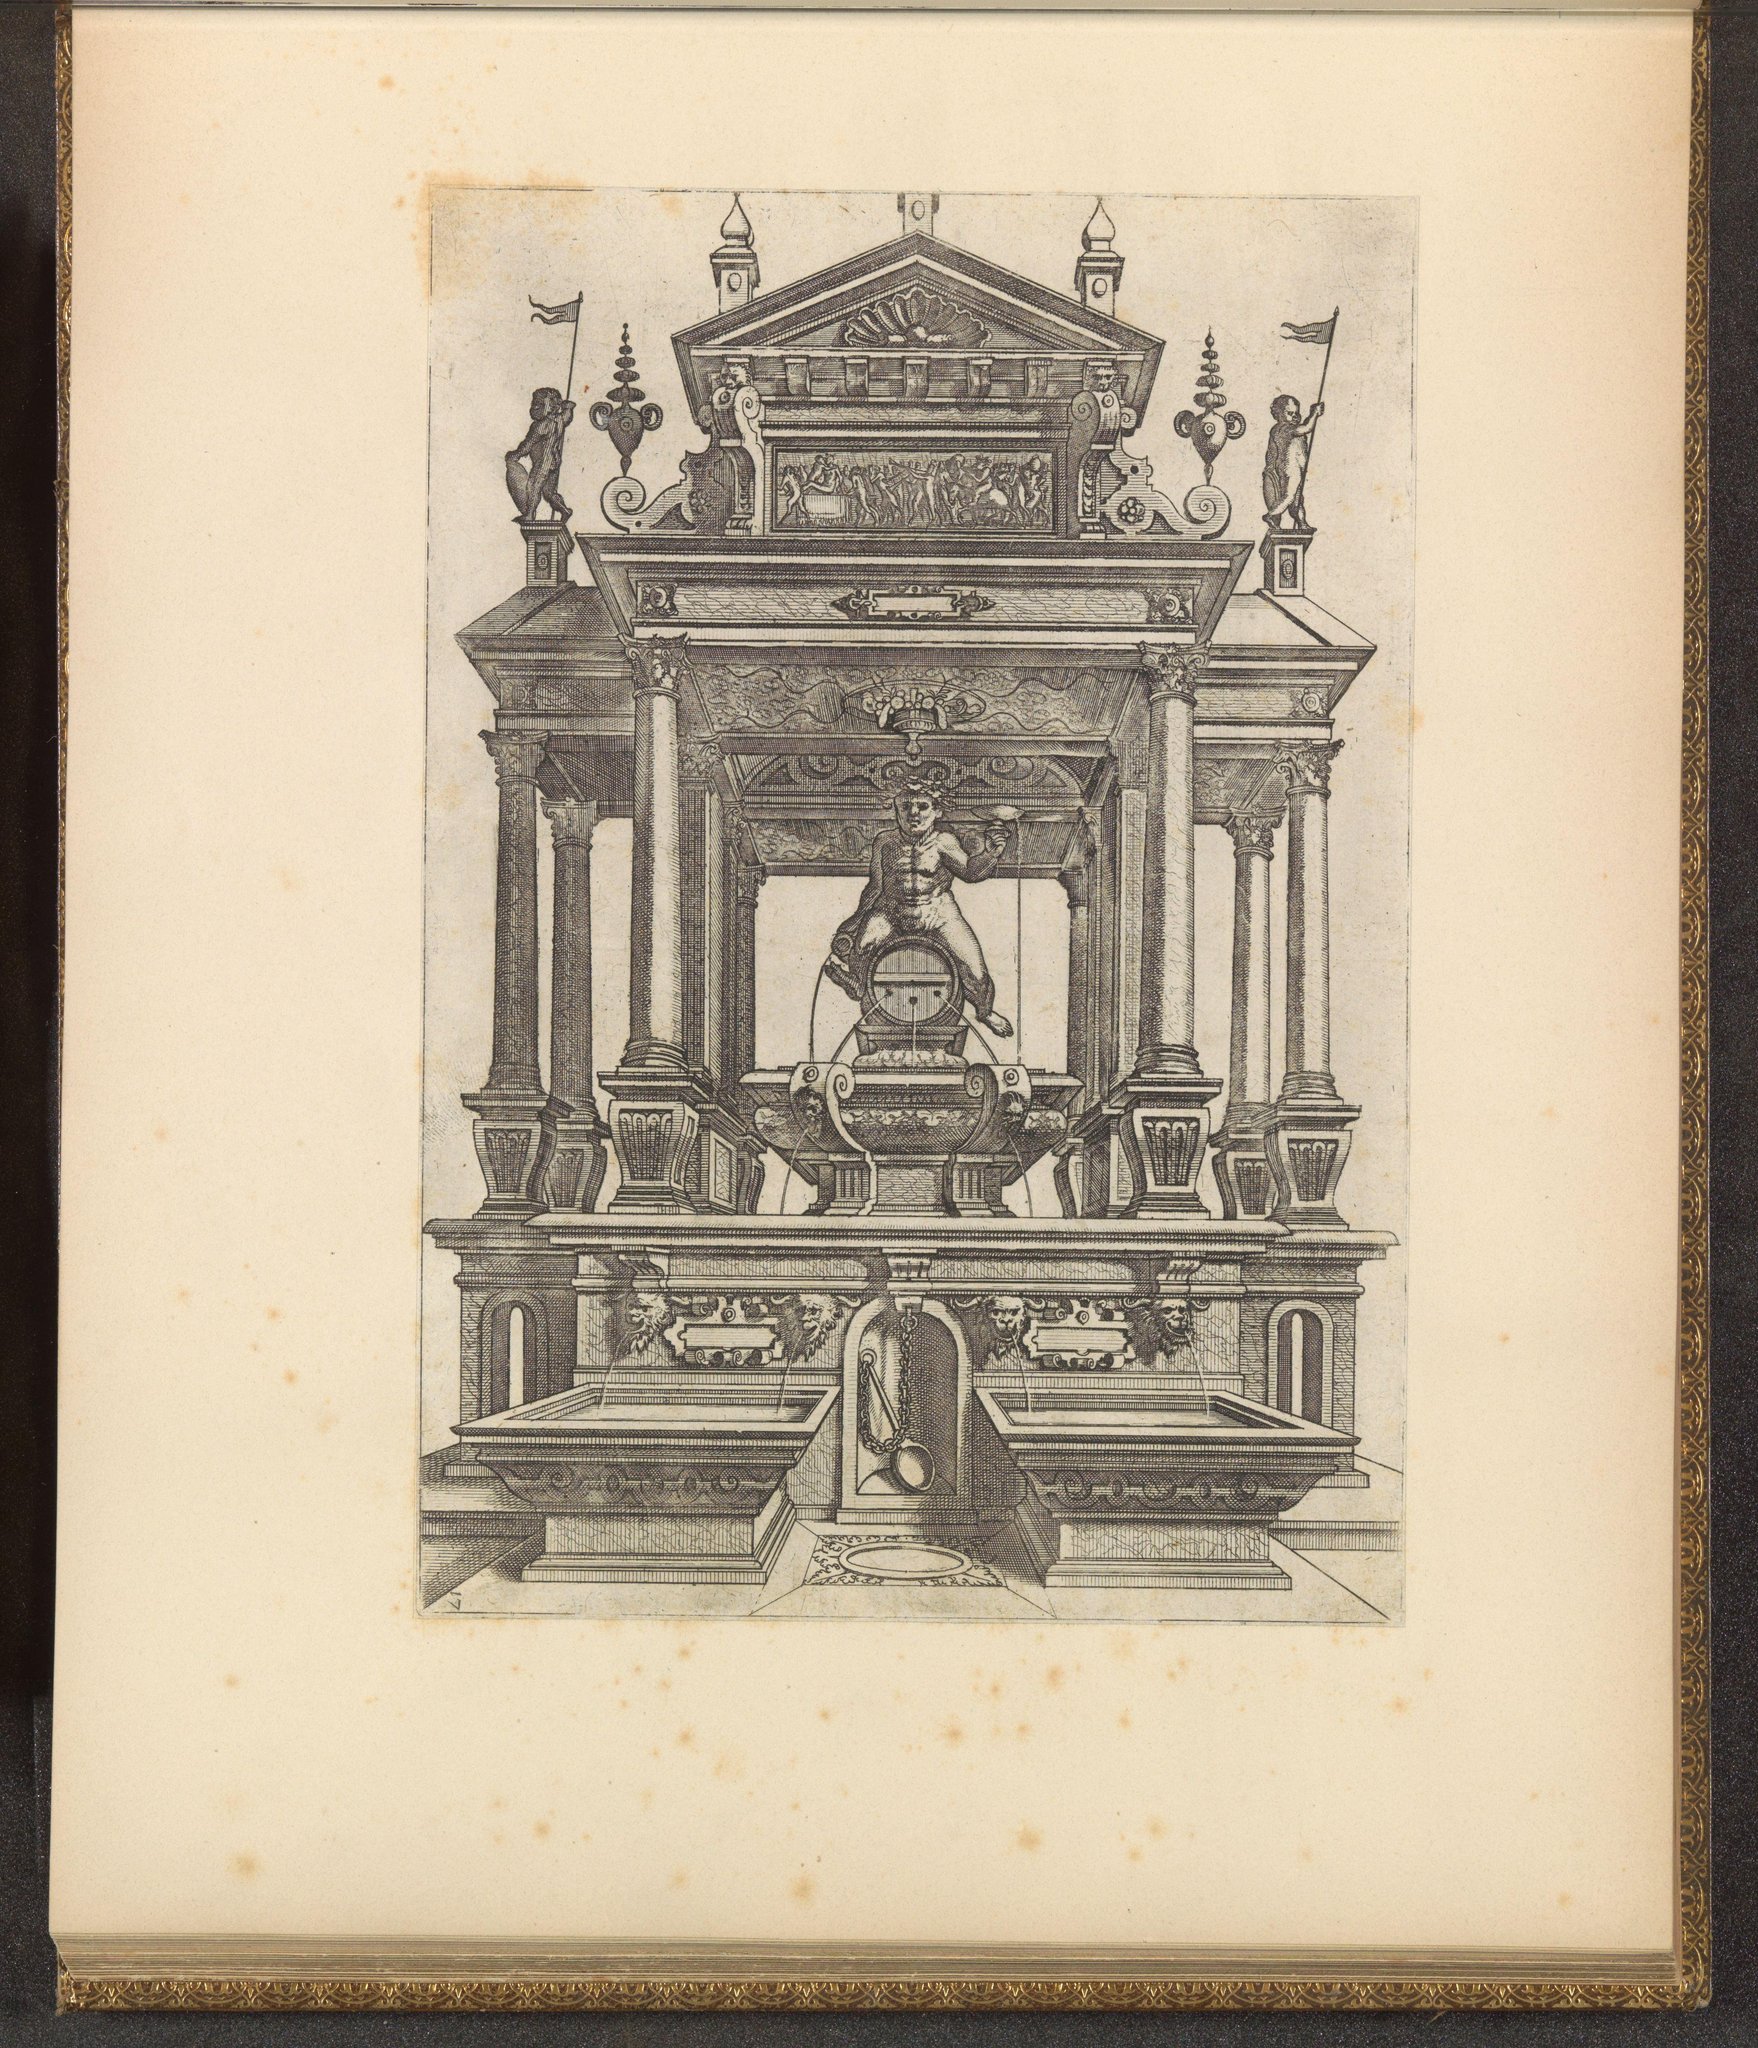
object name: print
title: Fontein en Bacchus op een ton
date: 1600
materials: paper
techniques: etching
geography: antwerp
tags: (story of) bacchus (dionysus), liber, ornamental fountain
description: Vrijstaande fontein in de vorm van een kruisvormig paviljoen op een voetstuk. Tegen het voetstuk liggen twee lage bekkens. In het paviljoen bevindt zich een derde bekken waarin een voetstuk staat. Daarop zit Bacchus op een ton. Op het hoofdgestel rust een opbouw met een fries met een bacchantenoptocht. De prent maakt deel uit van een album.